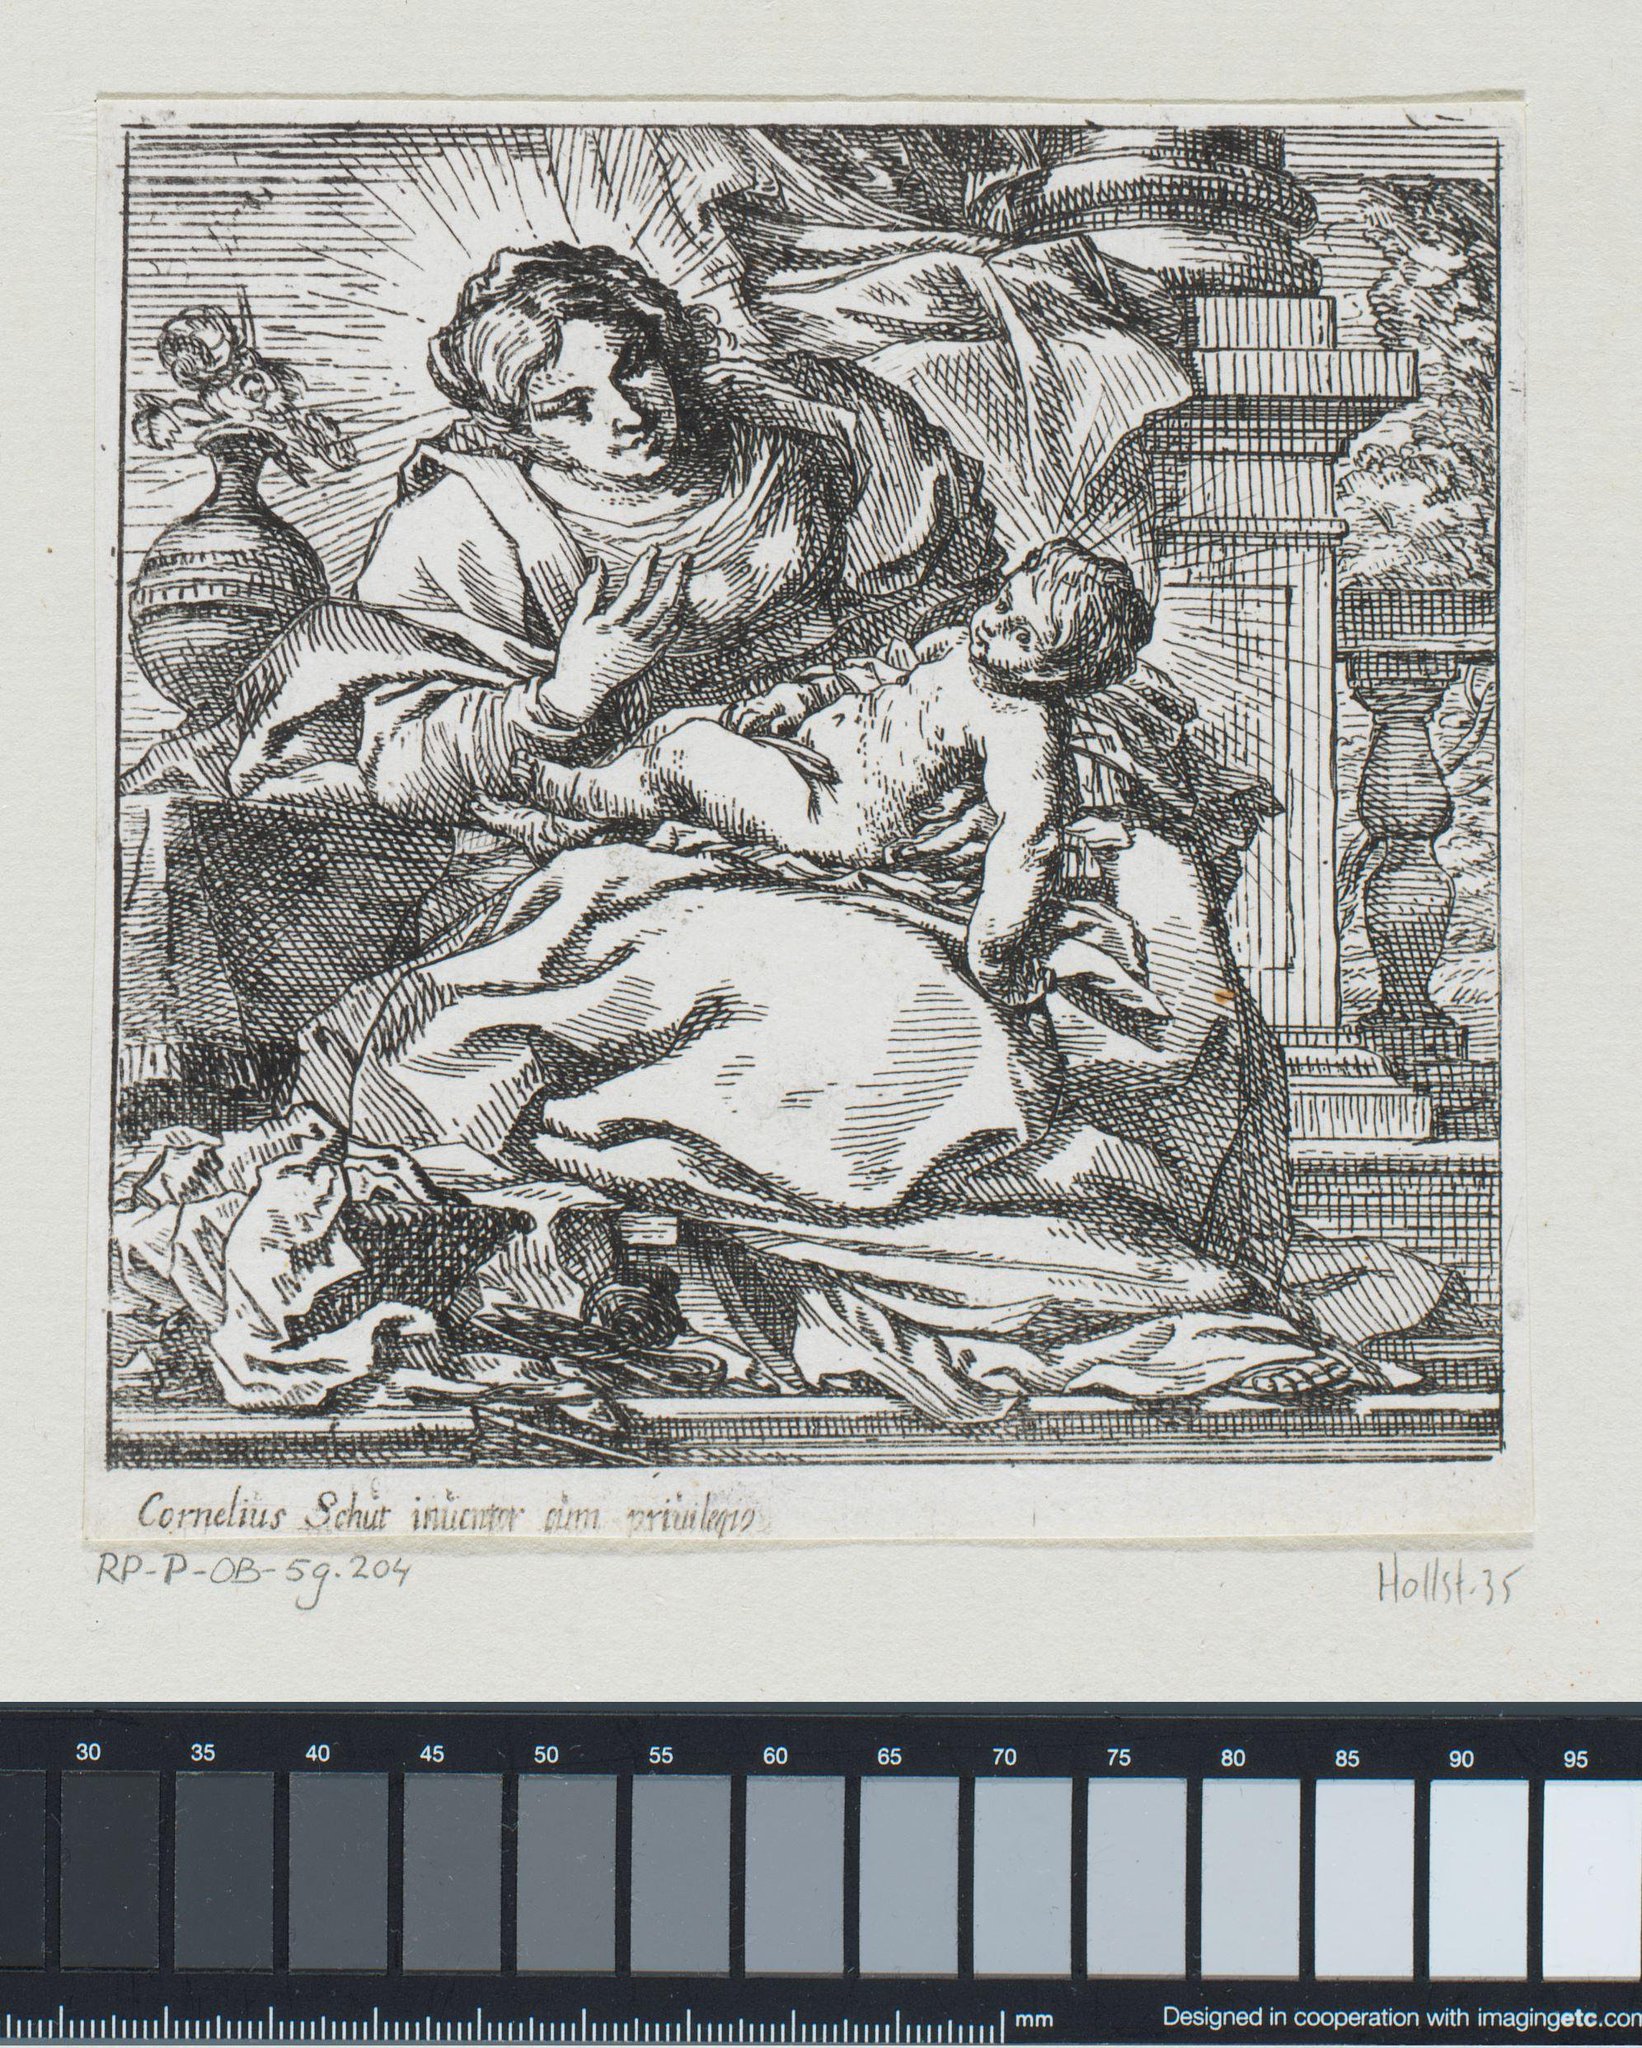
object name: print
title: Madonna met kind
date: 1618-1655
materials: paper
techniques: etching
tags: madonna: mary sitting or enthroned, the christ-child in her lap (or in front of her bosom) (mary sometimes represented half-length)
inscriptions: collector's mark: Lugt 240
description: Het Christuskind ligt bij Maria op schoot. Zij laat haar arm rusten op een tafel, waarop een vaas met bloemen staat. Op de achtergrond is een zuil met balustrade te zien met doorkijk naar een tuin.